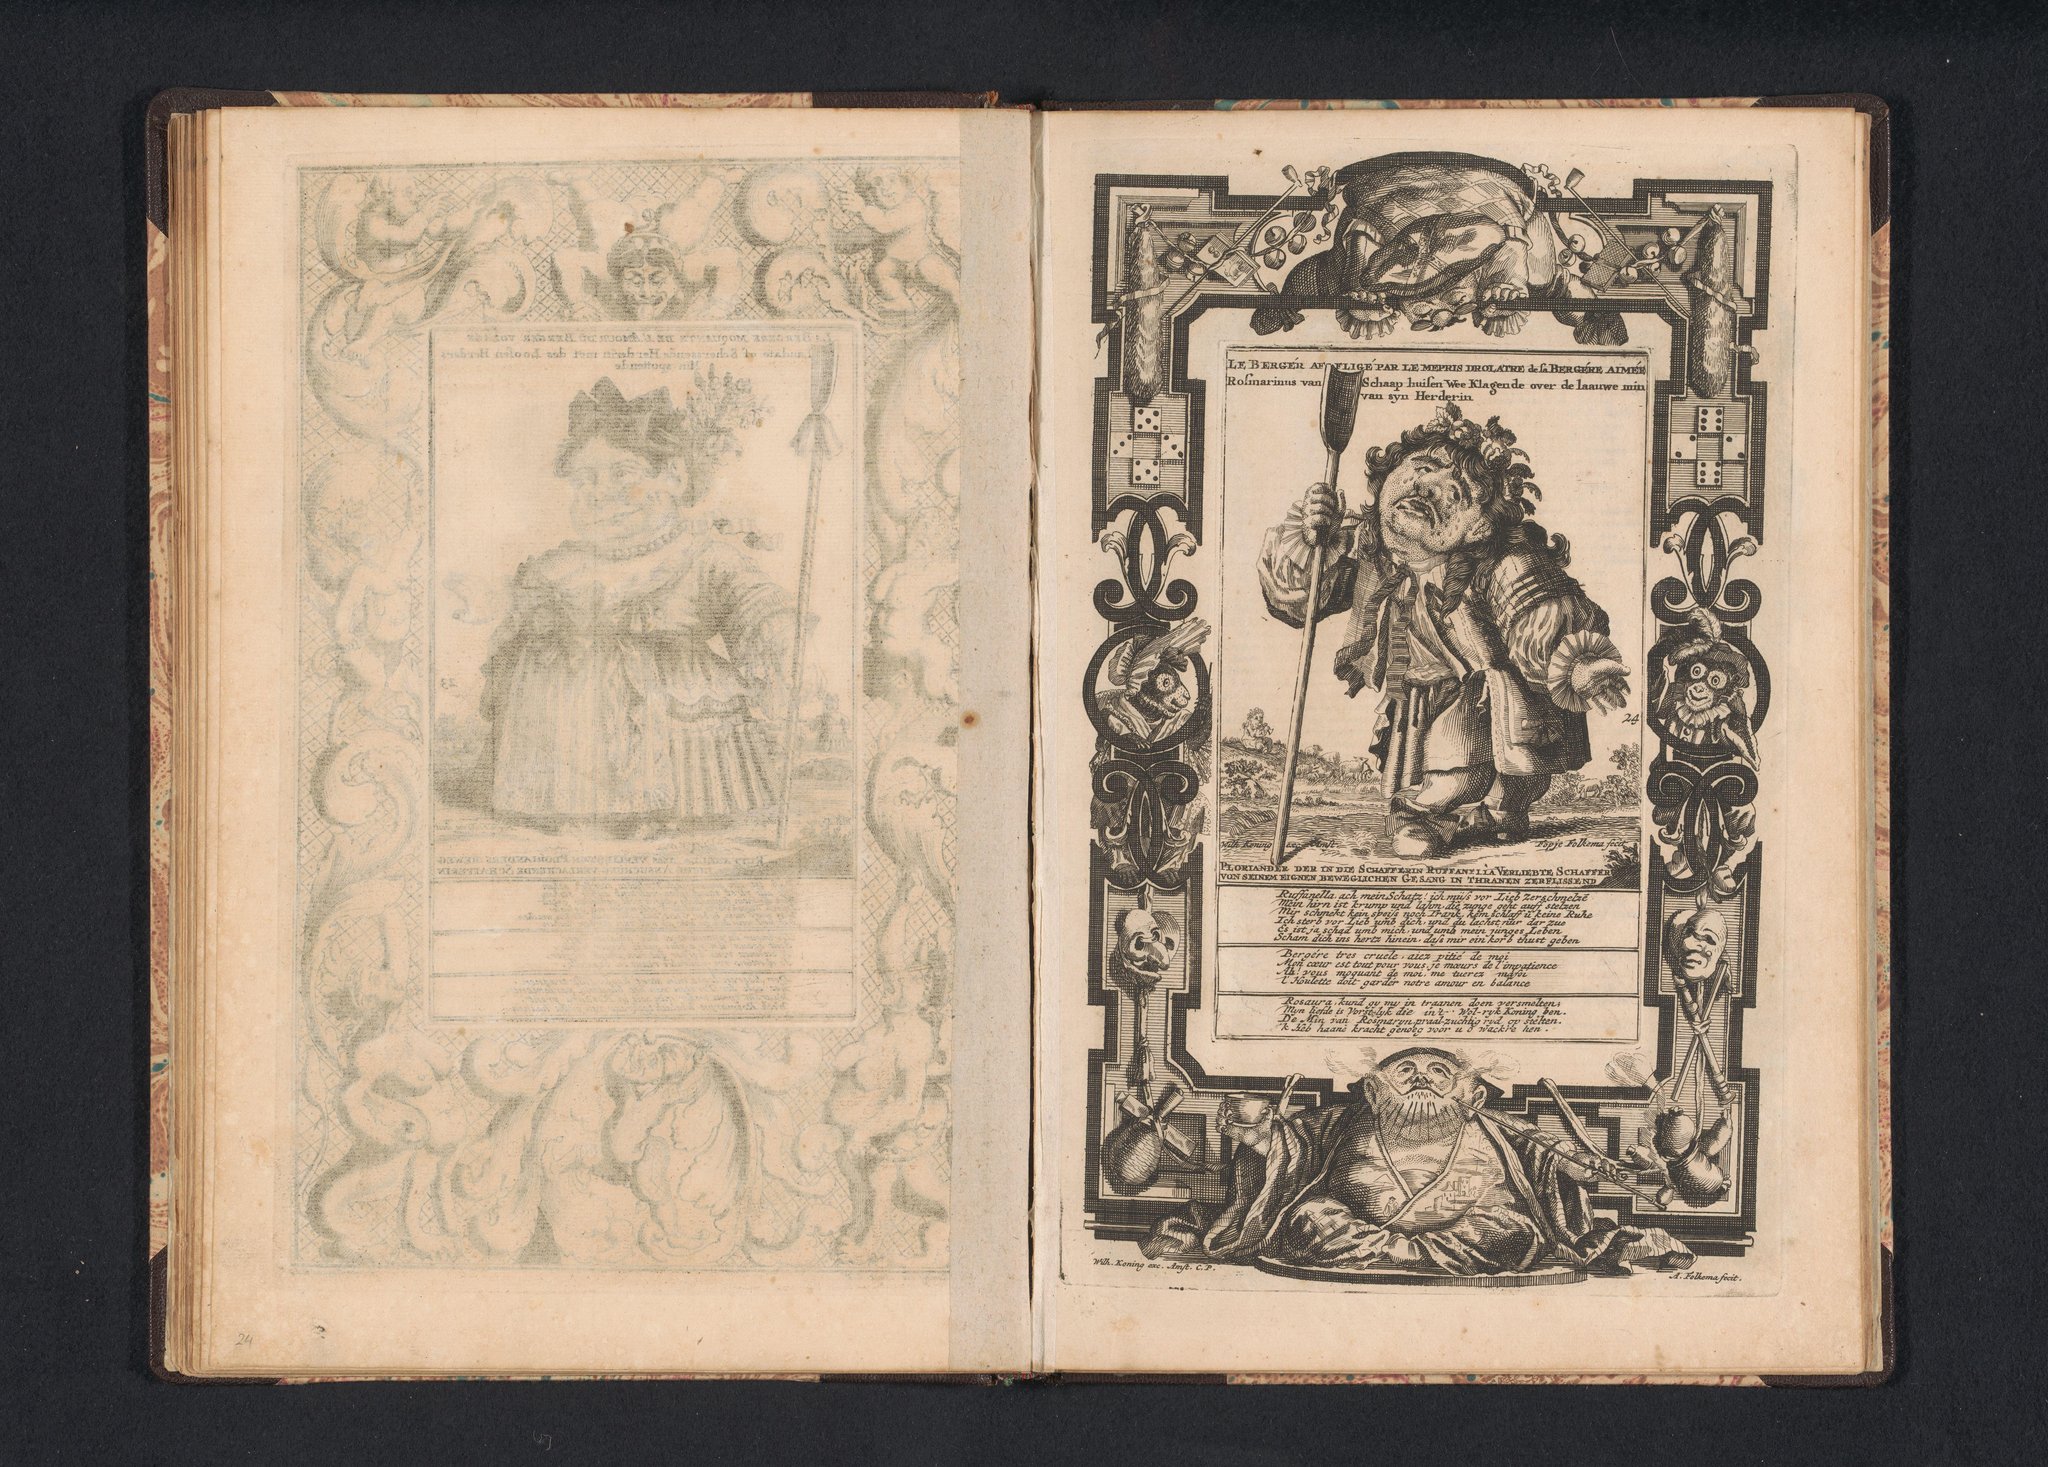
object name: print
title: Il Callotto resuscitato oder Neü eingerichtes Zwerchen Cabinet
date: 1716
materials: paper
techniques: etching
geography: amsterdam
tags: caricatures (human types), opium-pipe, herding, herdsman, herdswoman, shepherd, shepherdess, cowherd, etc., little people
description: De kleine mens Rosmarinus van Schaaphuisen, de herder op wie Laudate of Scherssende Herderin verliefd is. In het onderschrift verzen in het Duits, Frans en Nederlands. Afdruk binnen een decoratieve omlijsting gedrukt van een aparte plaat met verklede apen, onderaan een rokende Chinese kleine mens met een opiumpijp. Genummerd rechts midden: 24. Onderdeel van de Nederlandse gebonden uitgave uit 1716 van een serie karikaturen van kleine mensen, bekend als Het Dwergentooneel, gekopieerd naar een ouder Duits voorbeeld.